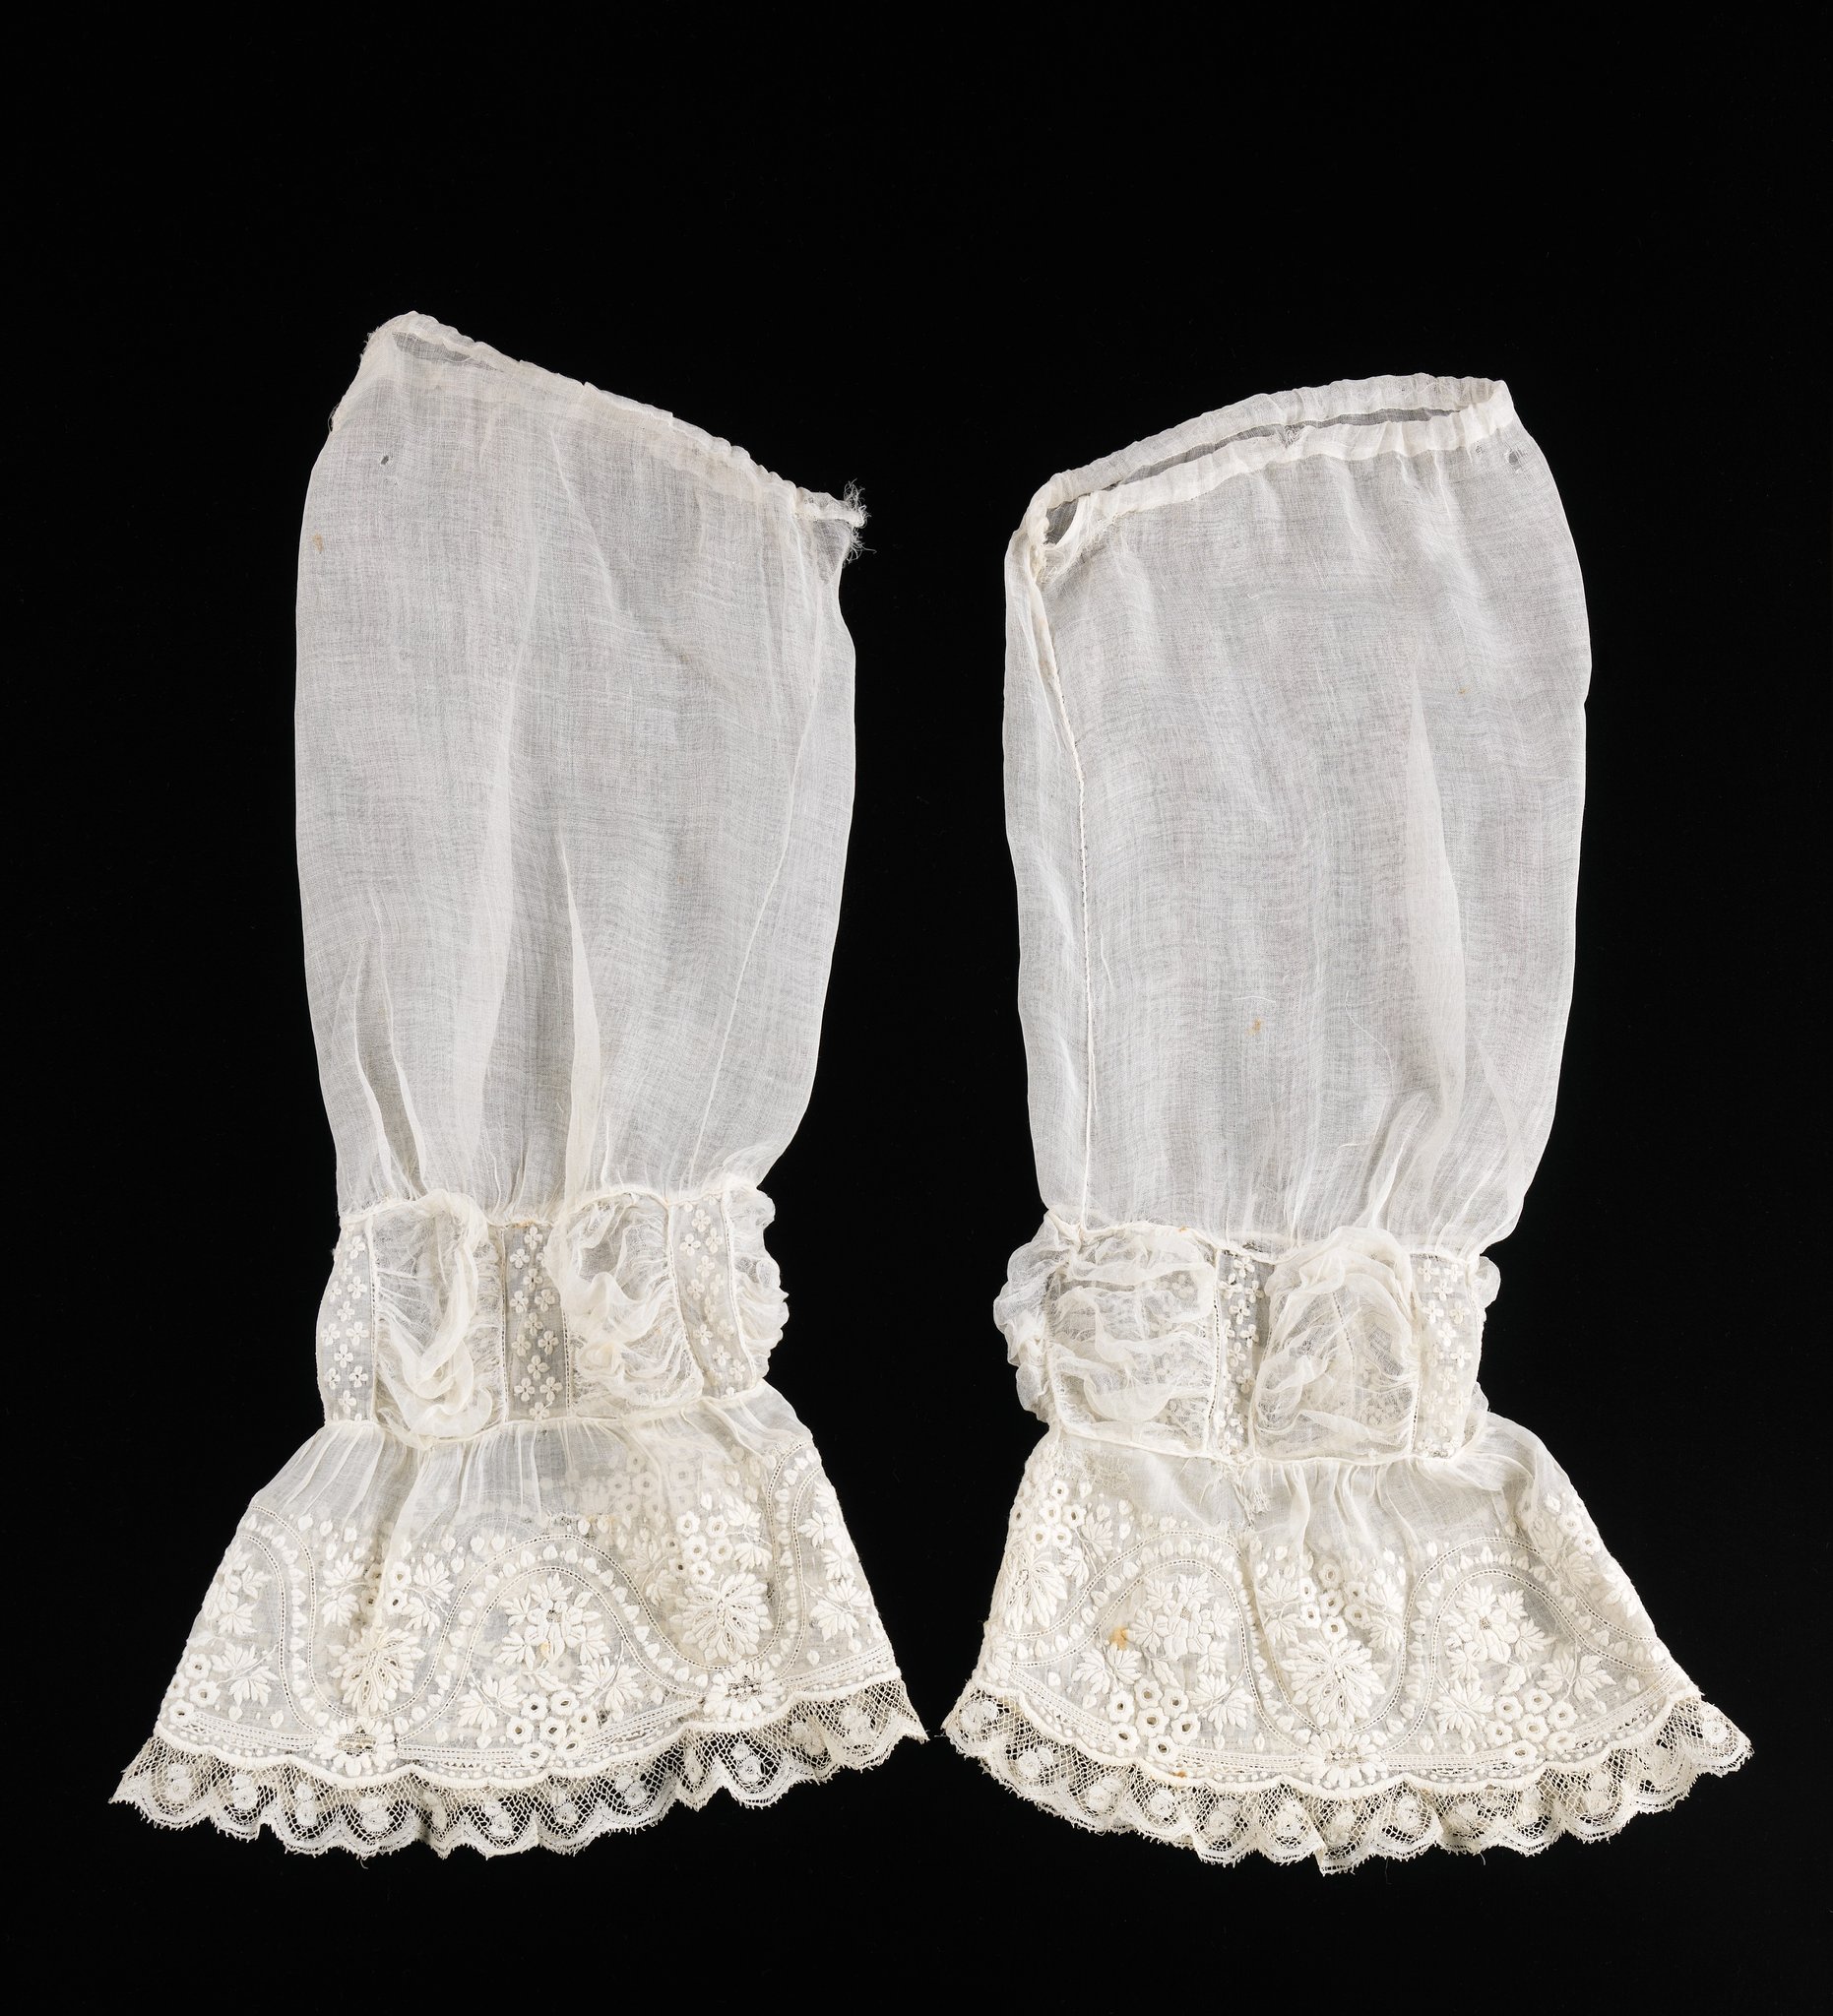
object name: undersleeves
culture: american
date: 1855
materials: cotton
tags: flowers